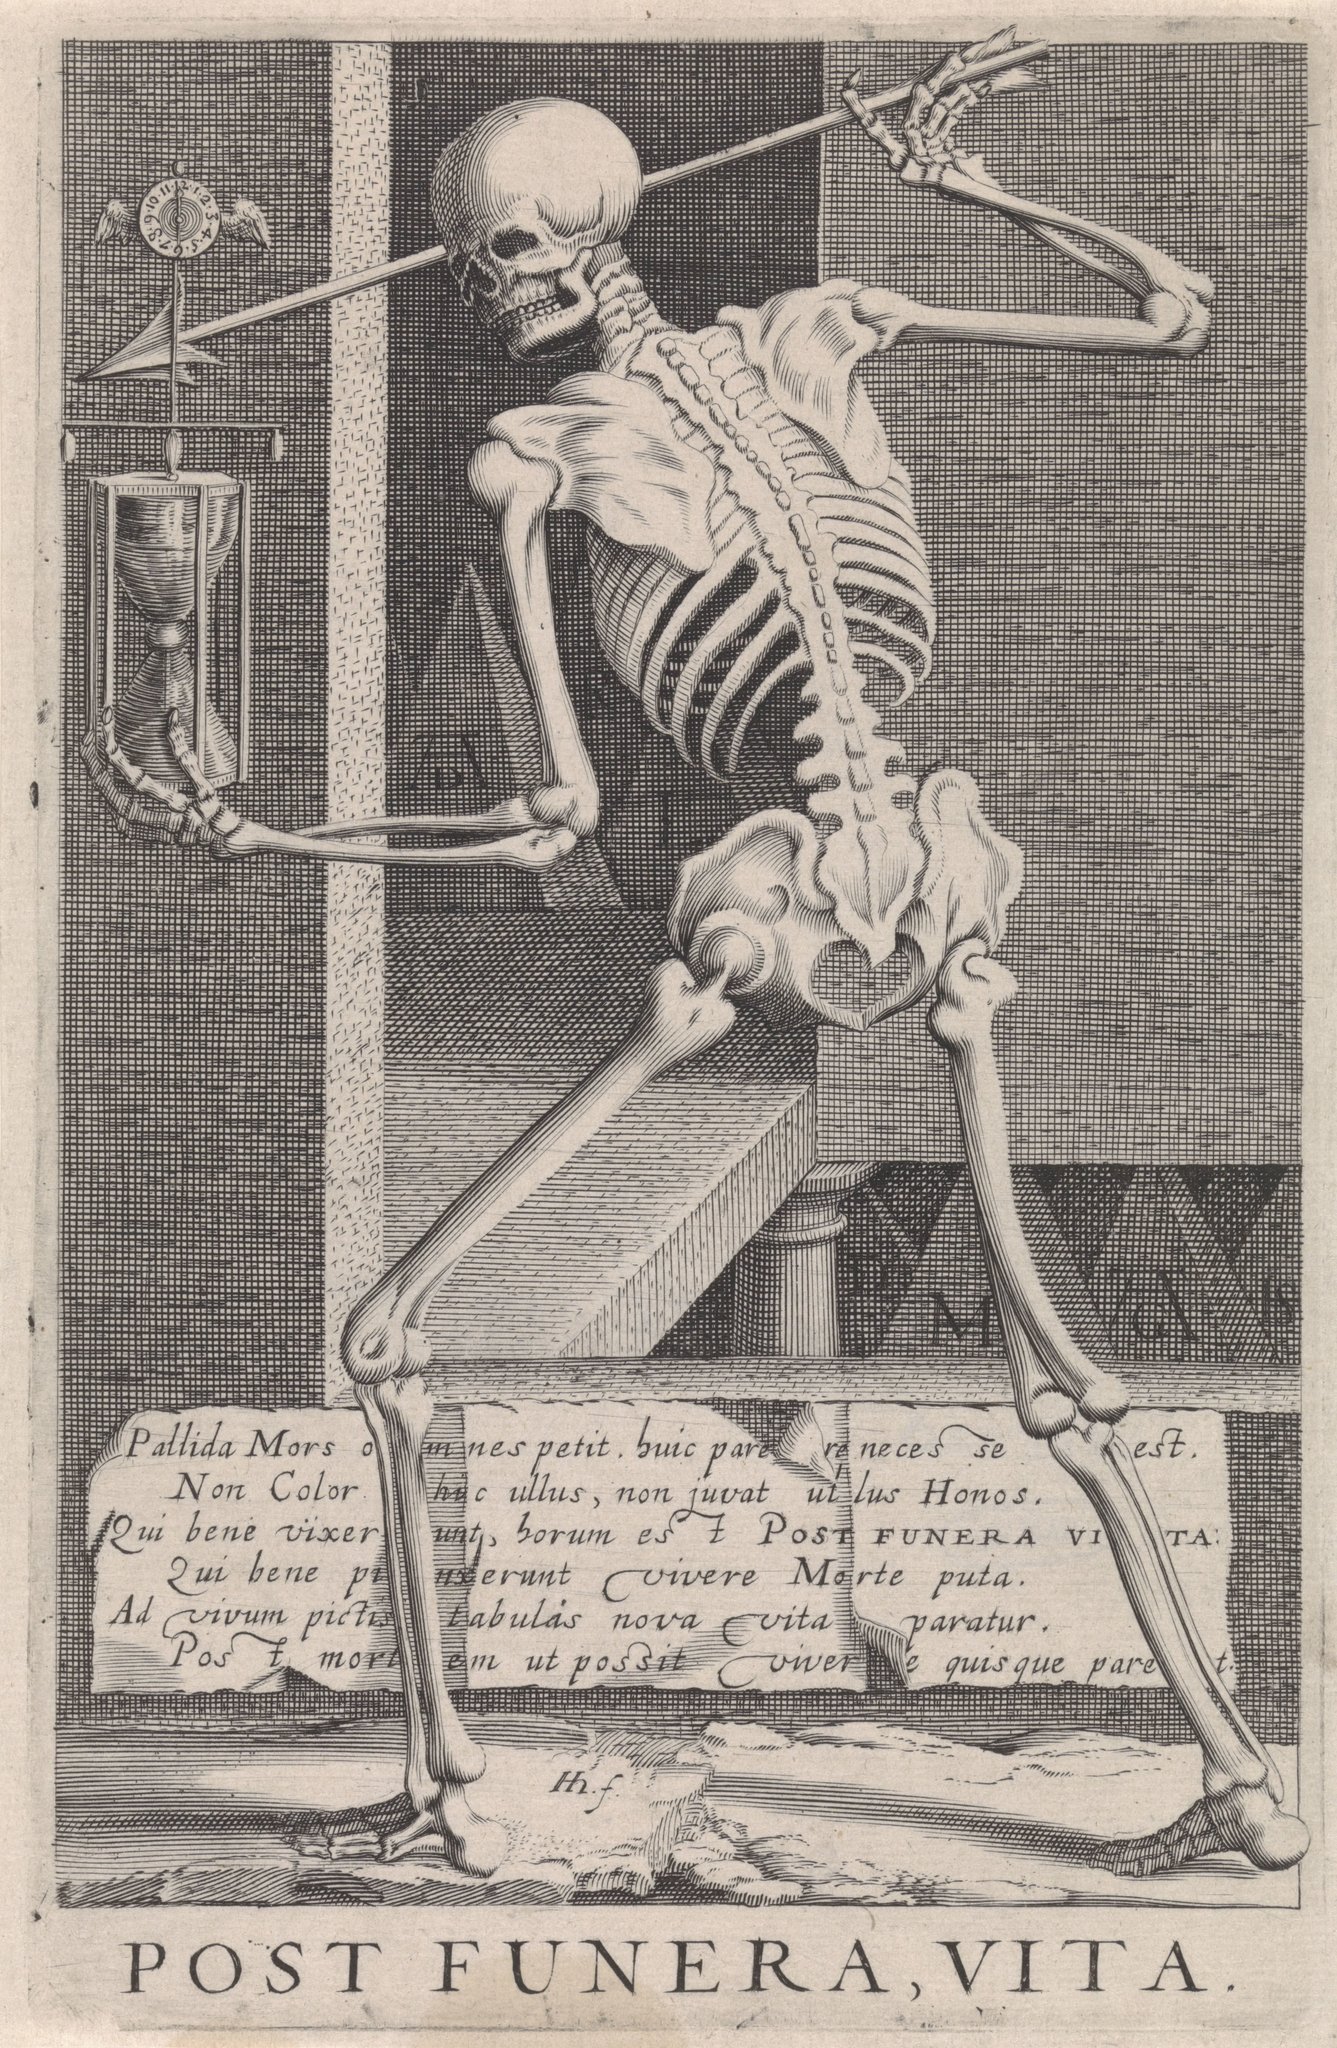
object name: print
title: Portretten van beroemde schilders uit de Lage Landen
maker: hendrick hondius (i)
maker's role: draughtsman, print maker, publisher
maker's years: 1573-1650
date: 1610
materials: paper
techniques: engraving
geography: the hague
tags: portrait, self-portrait of painter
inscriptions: collector's mark: Lugt 2228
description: Allegorie op beroemdheid na de dood. De Dood als skelet met een zandloper en een pijl in zijn handen. Op de achtergrond diverse monogrammen van beroemde, overleden kunstenaars. Achter de Dood zes regels in het Latijn. Laatste prent, uit deel 3, van de serie Pictorum Aliquot Celebrium Praecipuae Germaniae Inferioris Effigies. Serie van 72 kunstenaarsportretten vervaardigd door Hendrick Hondius I, Simon Frisius, Andries Jacobsz. Stock en Robert de Baudous.